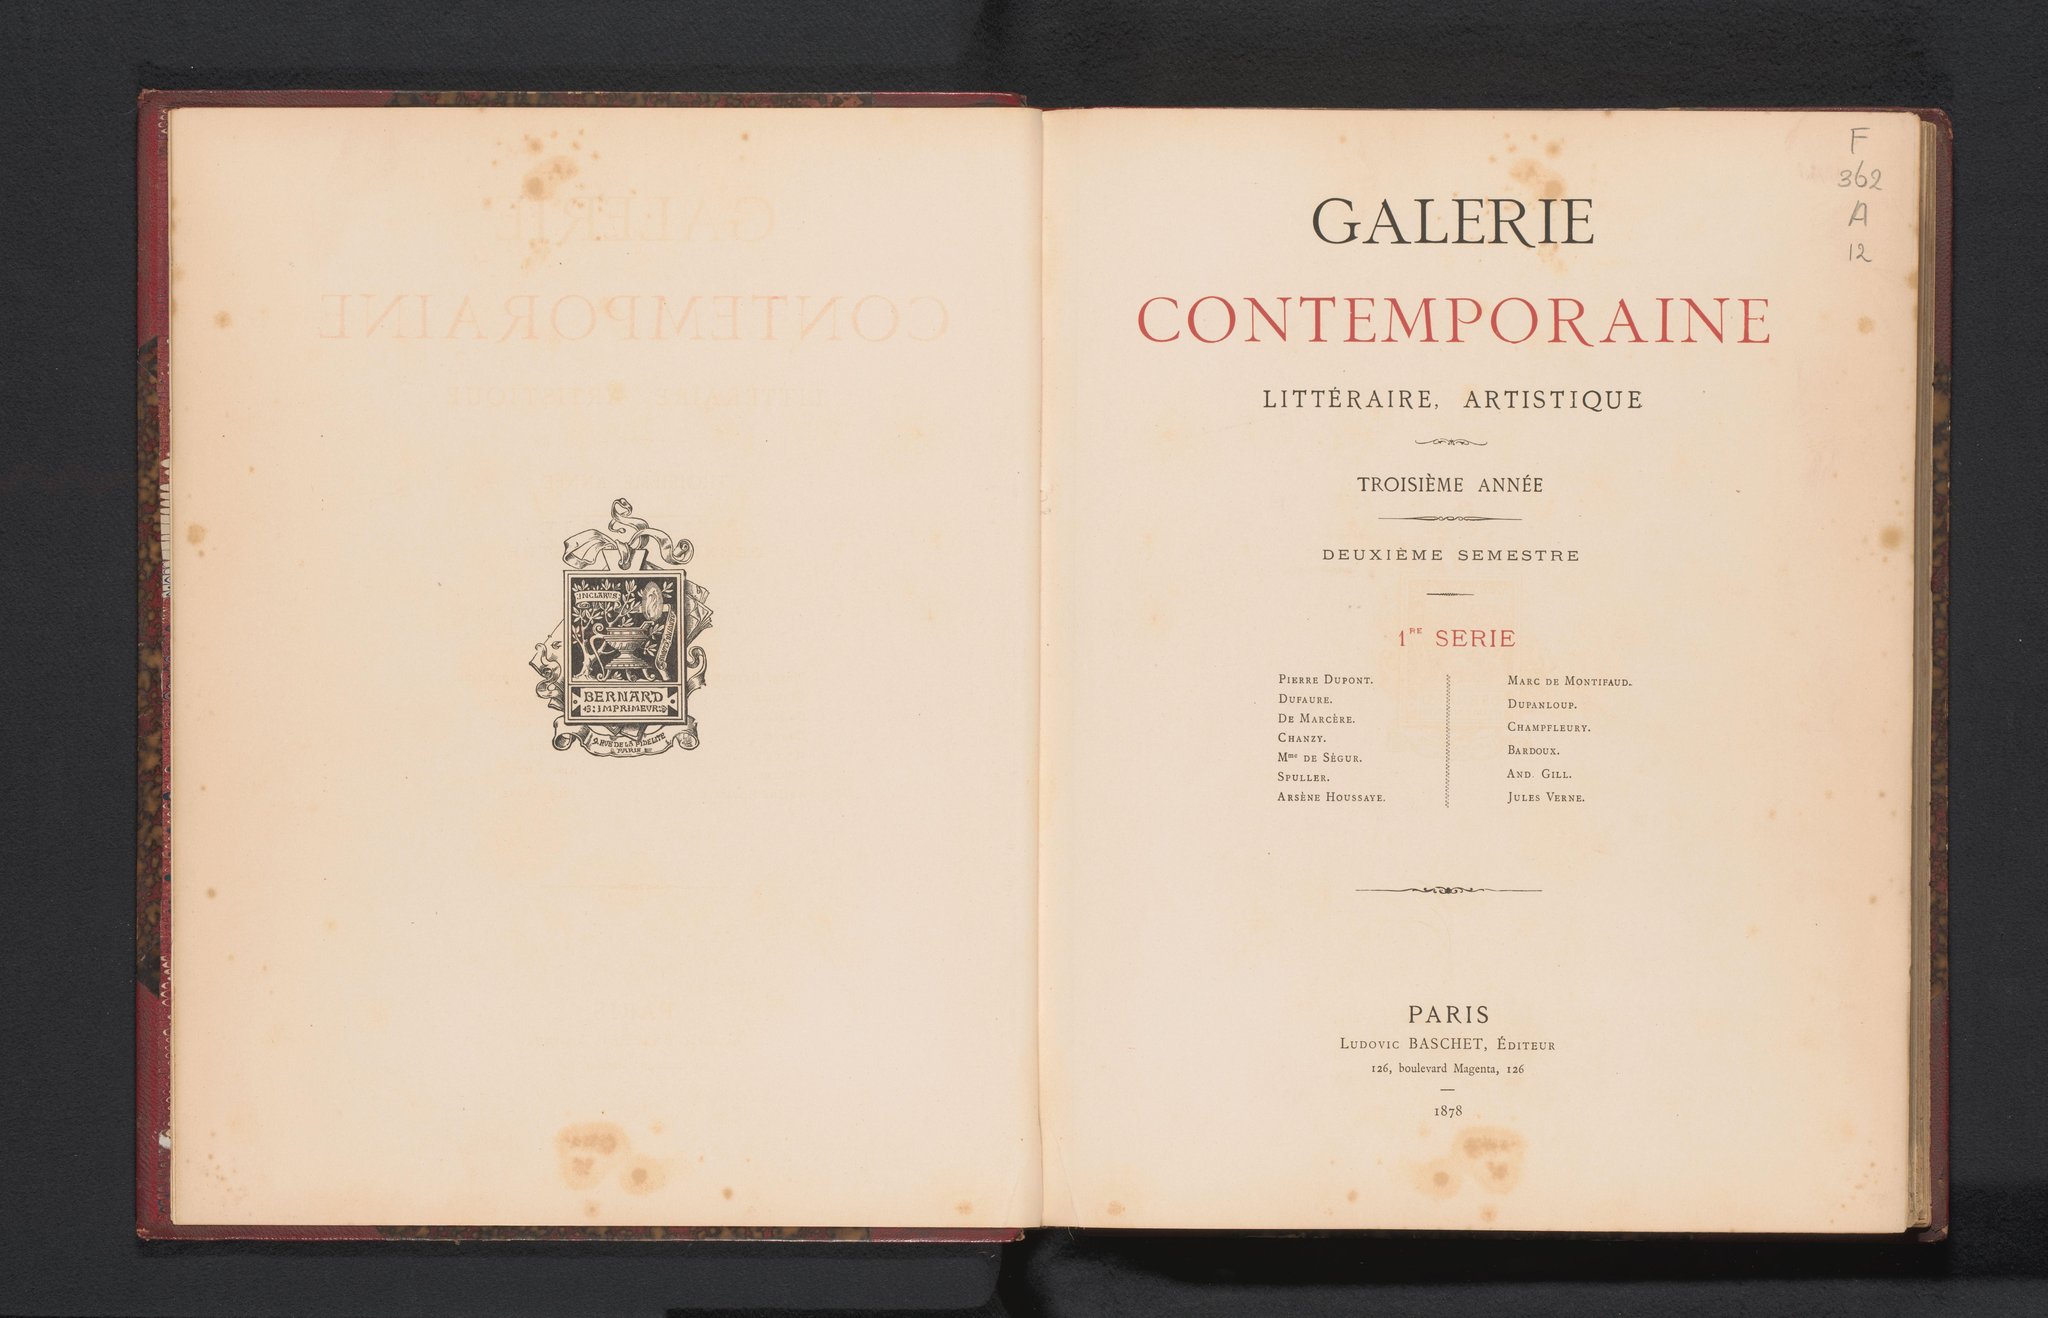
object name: book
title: Galerie contemporaine : litteraire, artistique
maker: ludovic baschet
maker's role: publisher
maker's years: 1834-1909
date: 1878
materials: paper, photographic support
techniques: marbled paper, printing, printing block, woodburytype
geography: paris